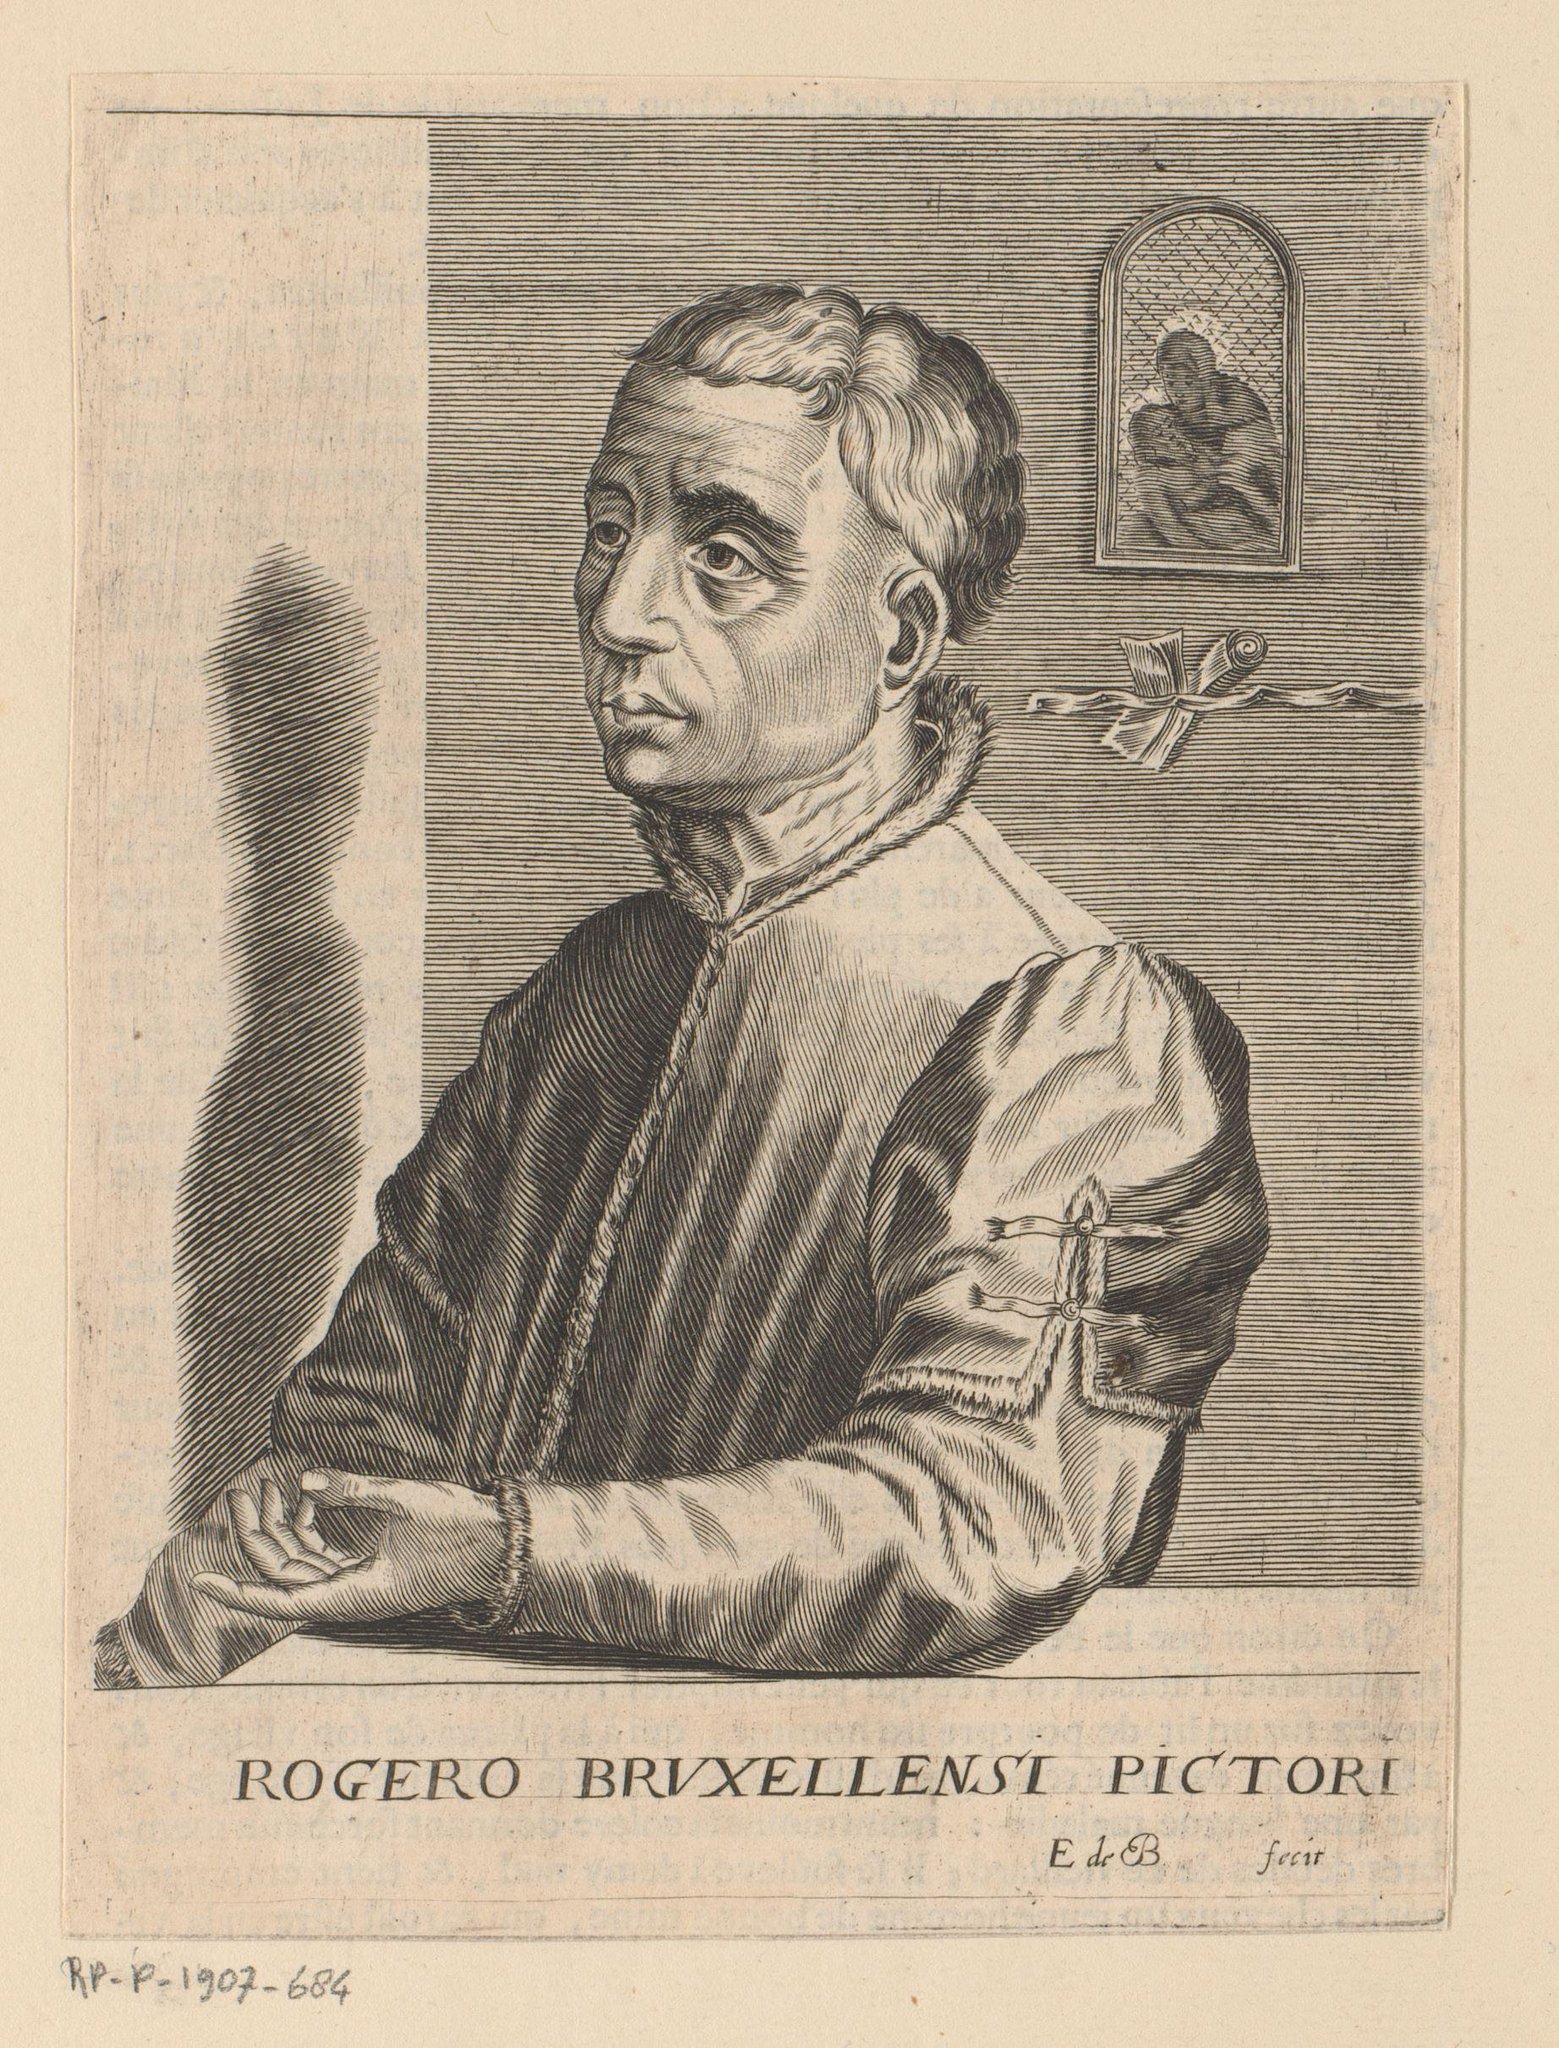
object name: book illustration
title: Portret van Rogier van der Weyden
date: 1682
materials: paper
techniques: engraving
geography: brussels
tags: brussels, painter, rogier van der weyden, historical persons, portrait, self-portrait of artist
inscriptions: collector's mark: Lugt 2228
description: Prent uit: Bullert, Isaac. Académie des Sciences et Arts contenant les vies et éloges his. des hommes illustres qui ont excellé en ces professions depuis environ quatre siècles. Brussel: Foppens, François, 1682. Het boek werd in 1682 eveneens in Amsterdam uitgegeven door de erfgenamen van Daniel Elzevier. Deze portretten dienen ter illustratie van de biografie van een kunstenaar of geleerde. De meeste portretten werden door Nicolas de Larmessin vervaardigd (162), 93 door De Boulonois en een derde door ongeïdentificeerde prentmakers. Dit betreft een illustratie op p. 387, deel II.